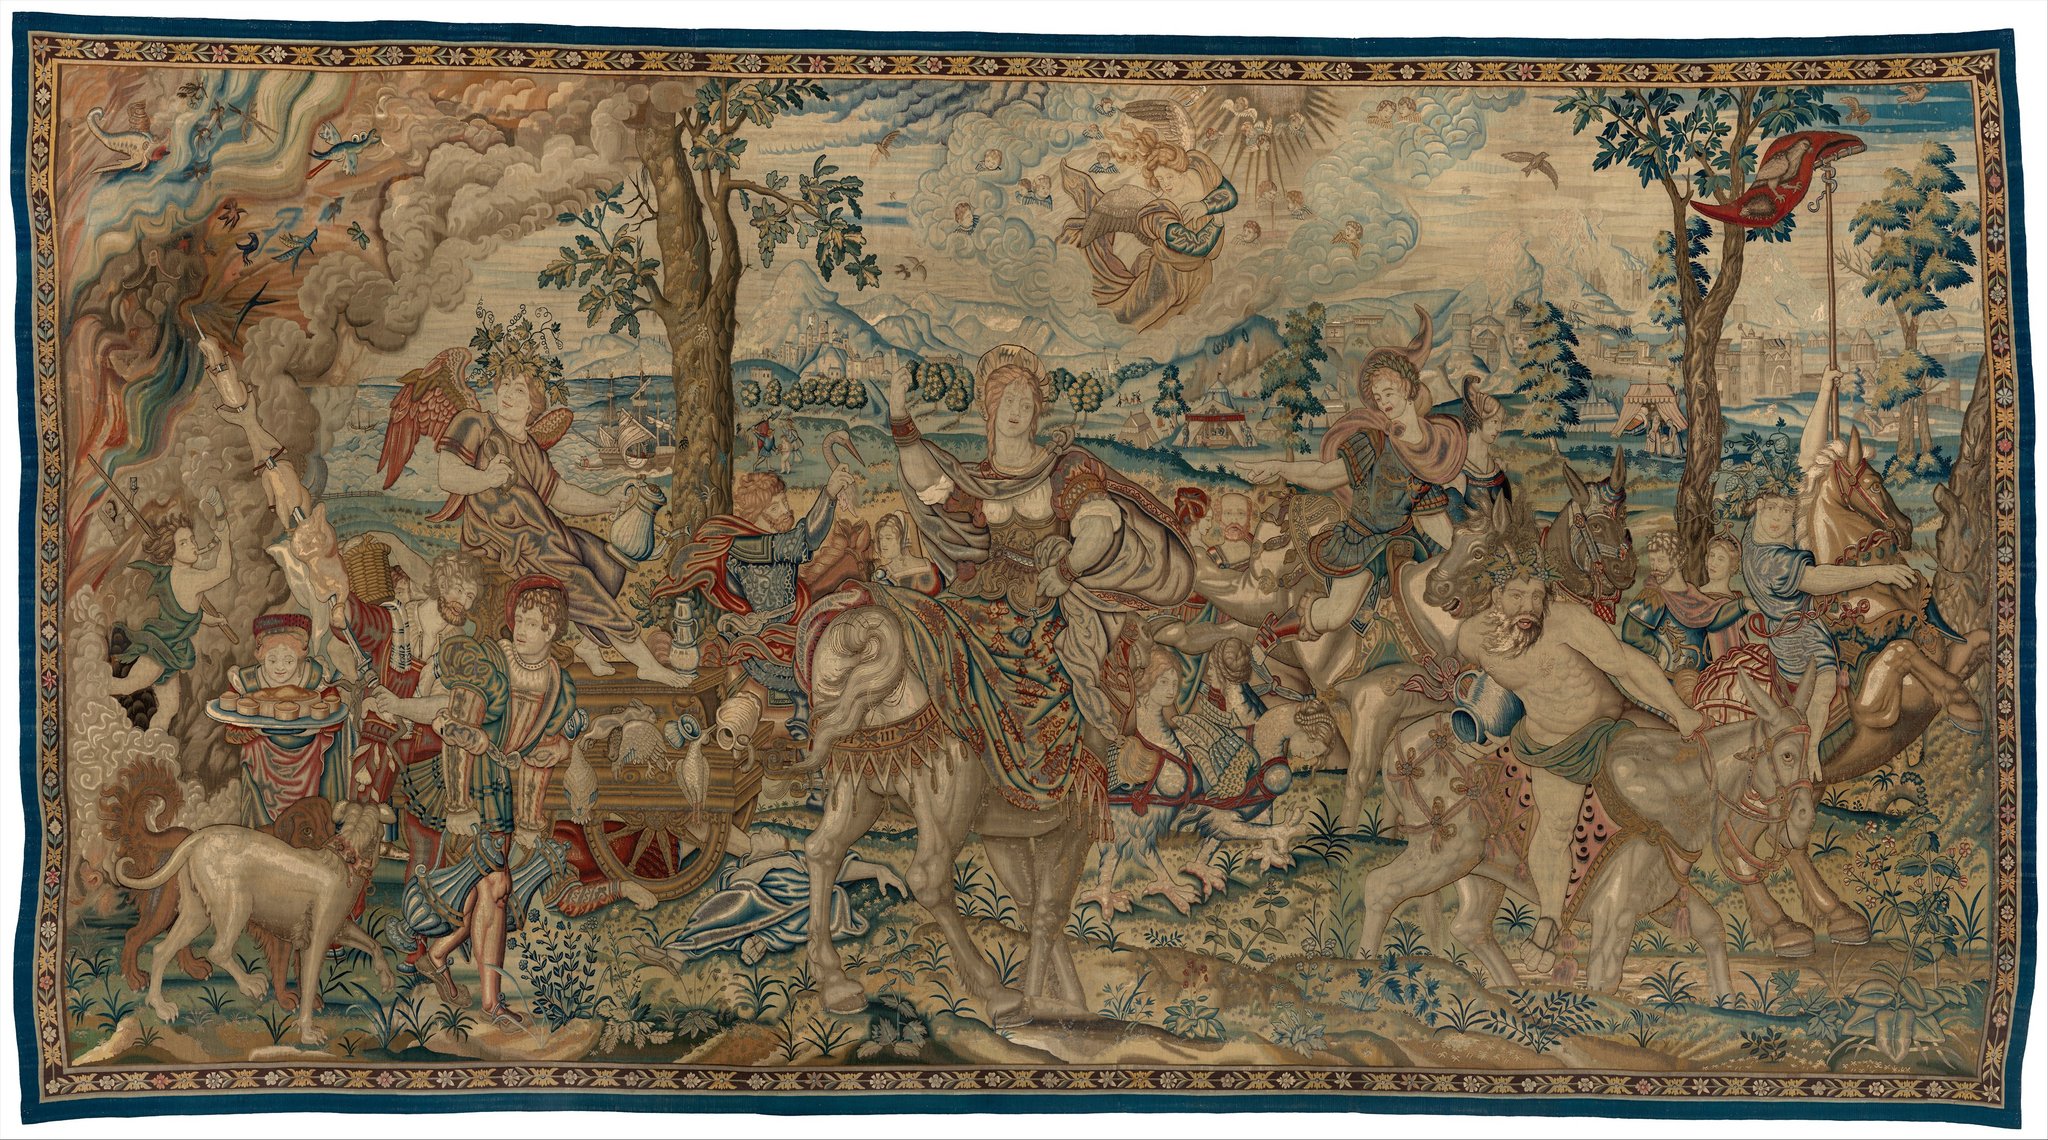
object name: tapestry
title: Gluttony from a set of The Seven Deadly Sins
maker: pieter coecke van aelst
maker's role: designer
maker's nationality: netherlandish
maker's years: 1502-1550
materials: silk, silver gilt, thread, wool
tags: alexander the great,cleopatra,bacchus,judith